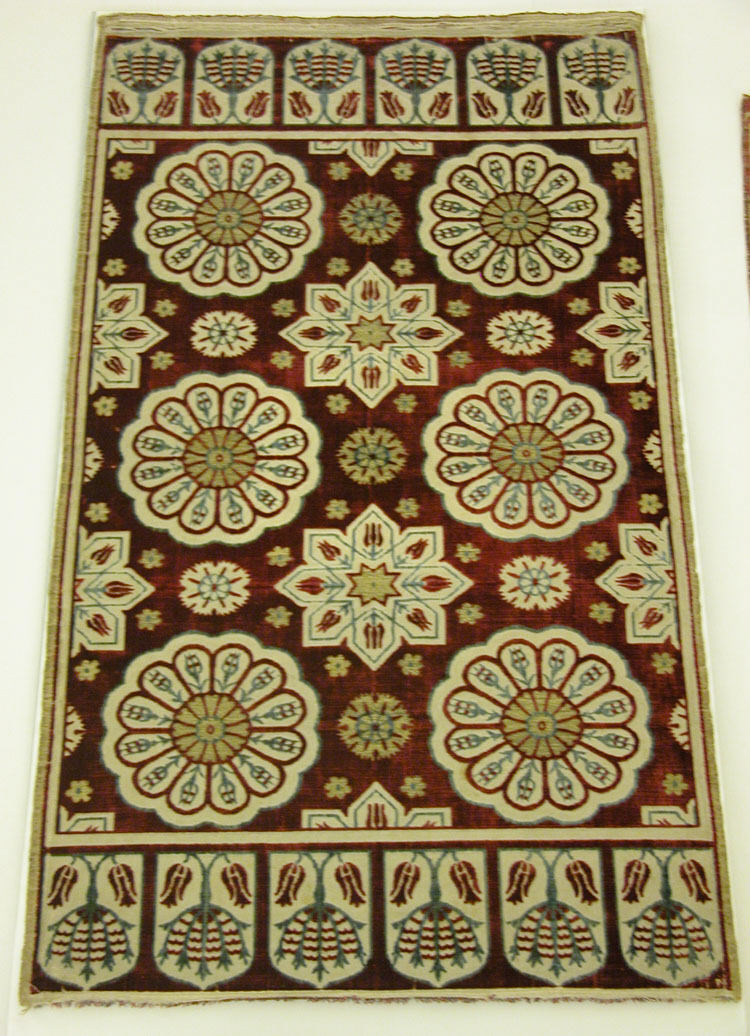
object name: cushion cover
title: Yastik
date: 1601-1700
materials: cotton, metal thread, silk, velvet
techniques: brocade, cutting, voiding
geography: turkey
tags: flowers